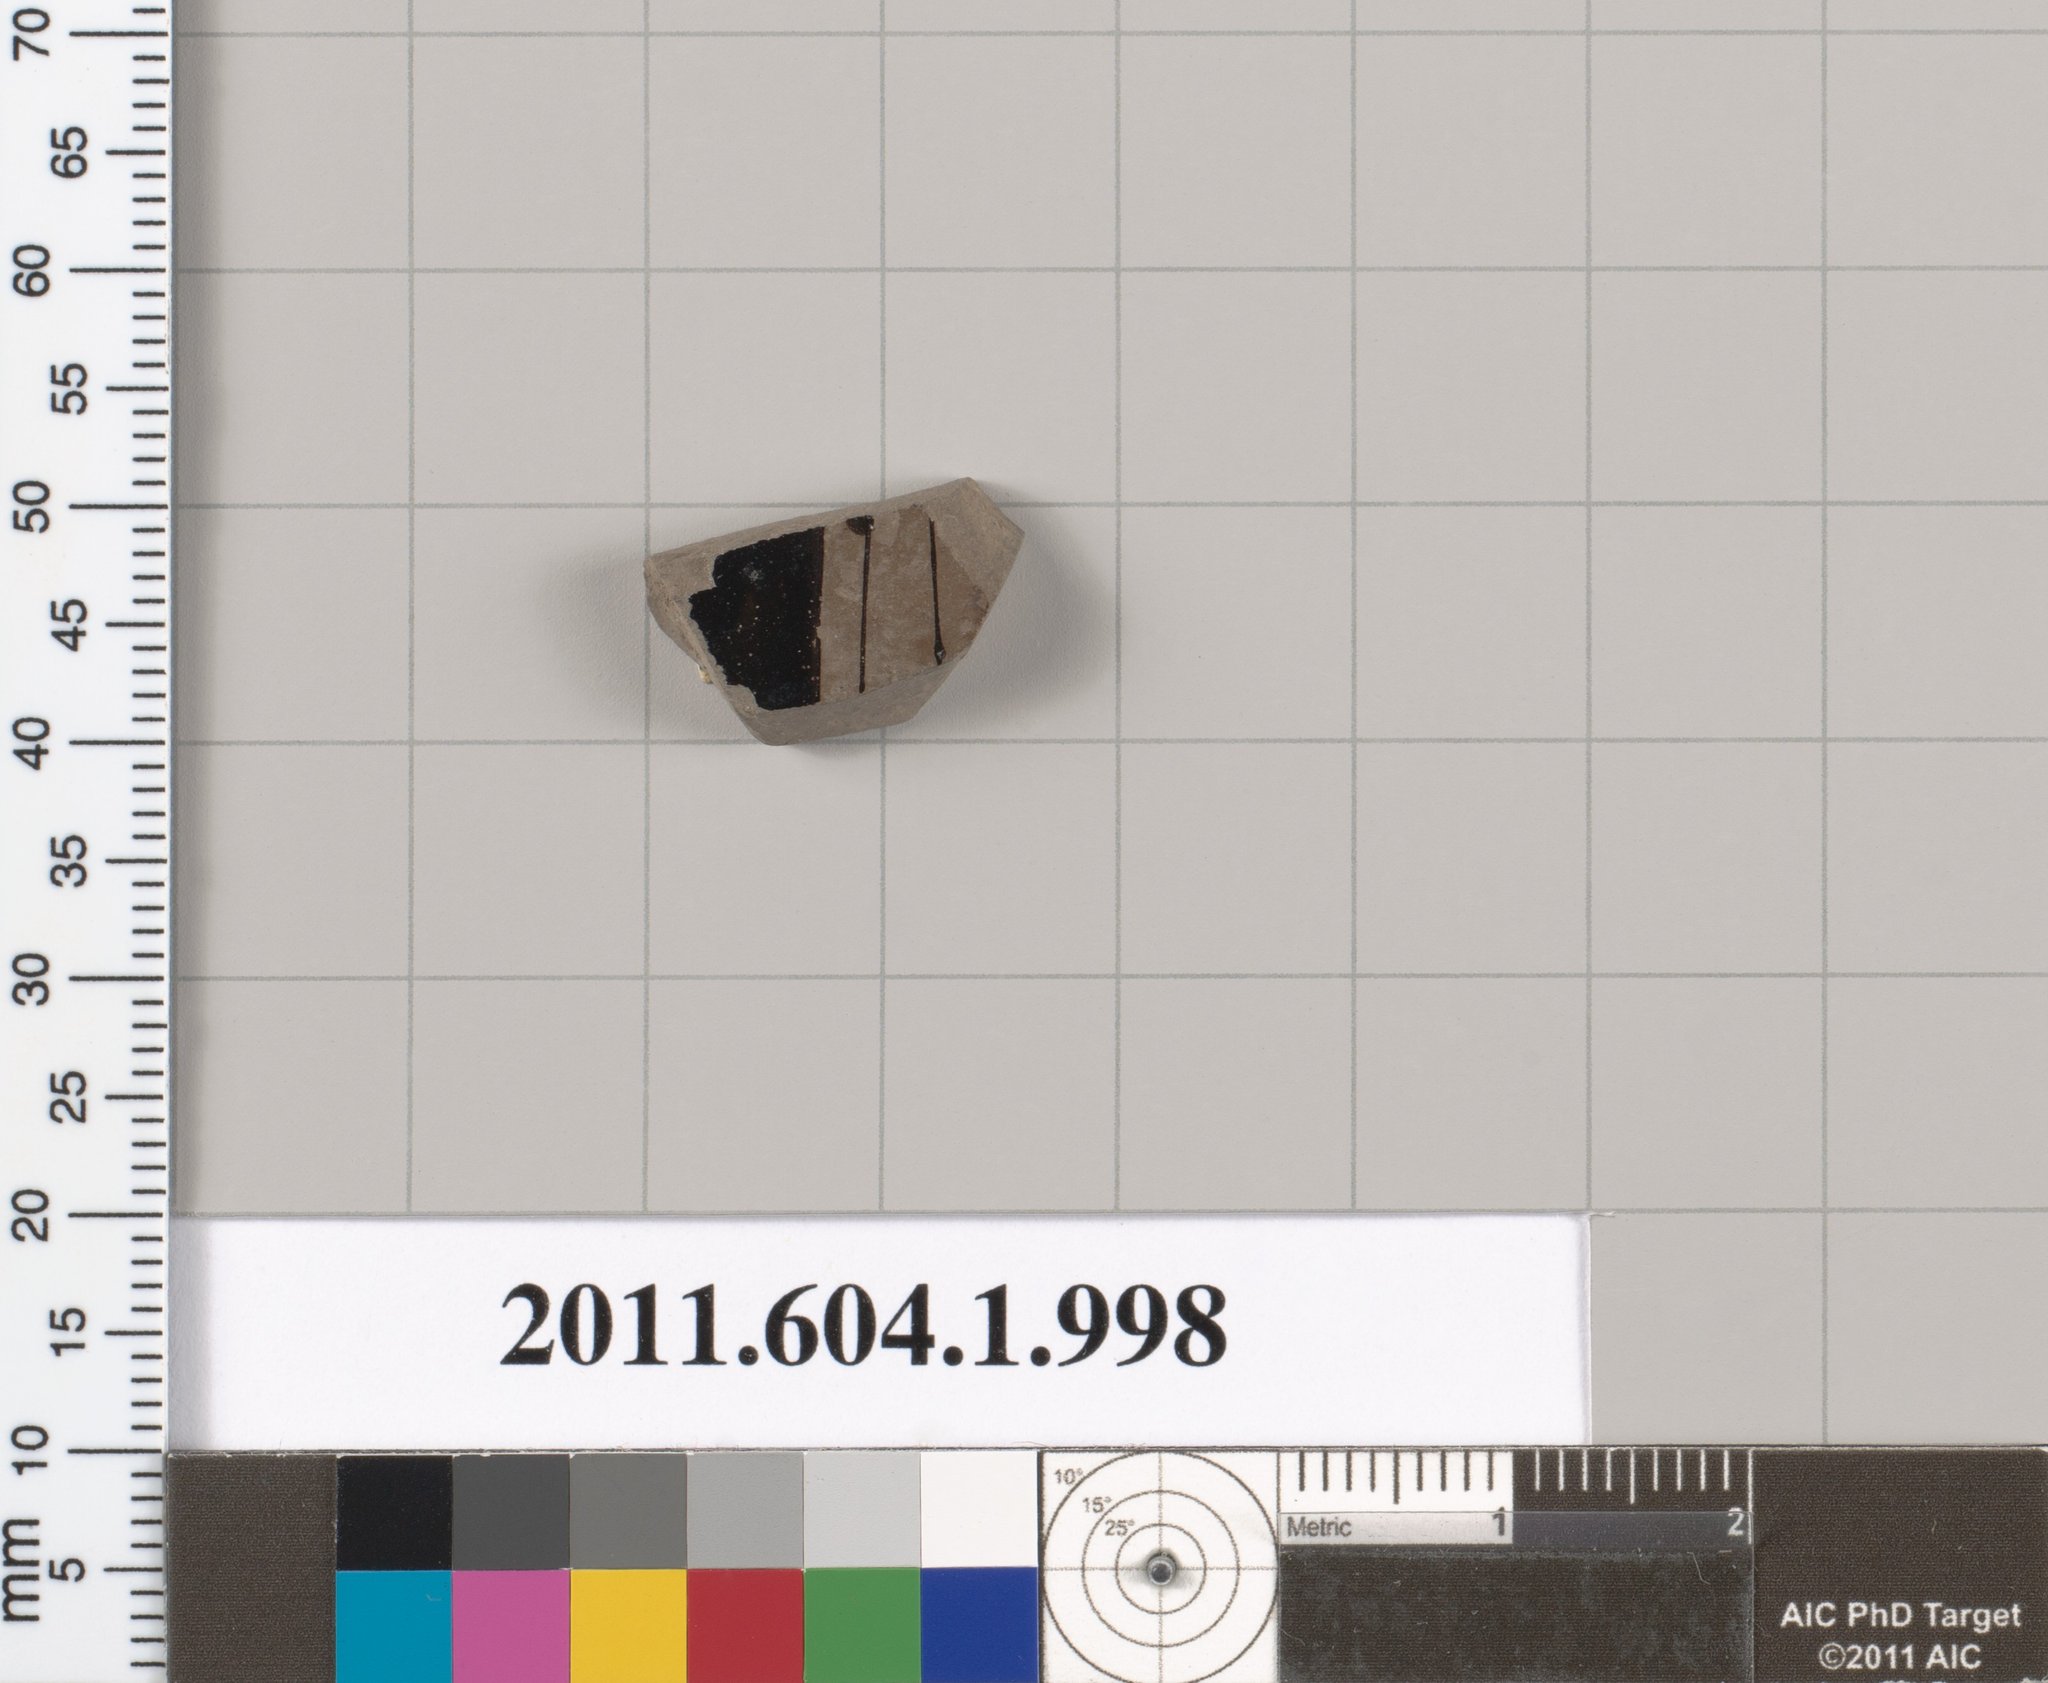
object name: kylix fragment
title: Terracotta fragment of a kylix (drinking cup)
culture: greek, attic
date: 475-451 BCE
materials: terracotta